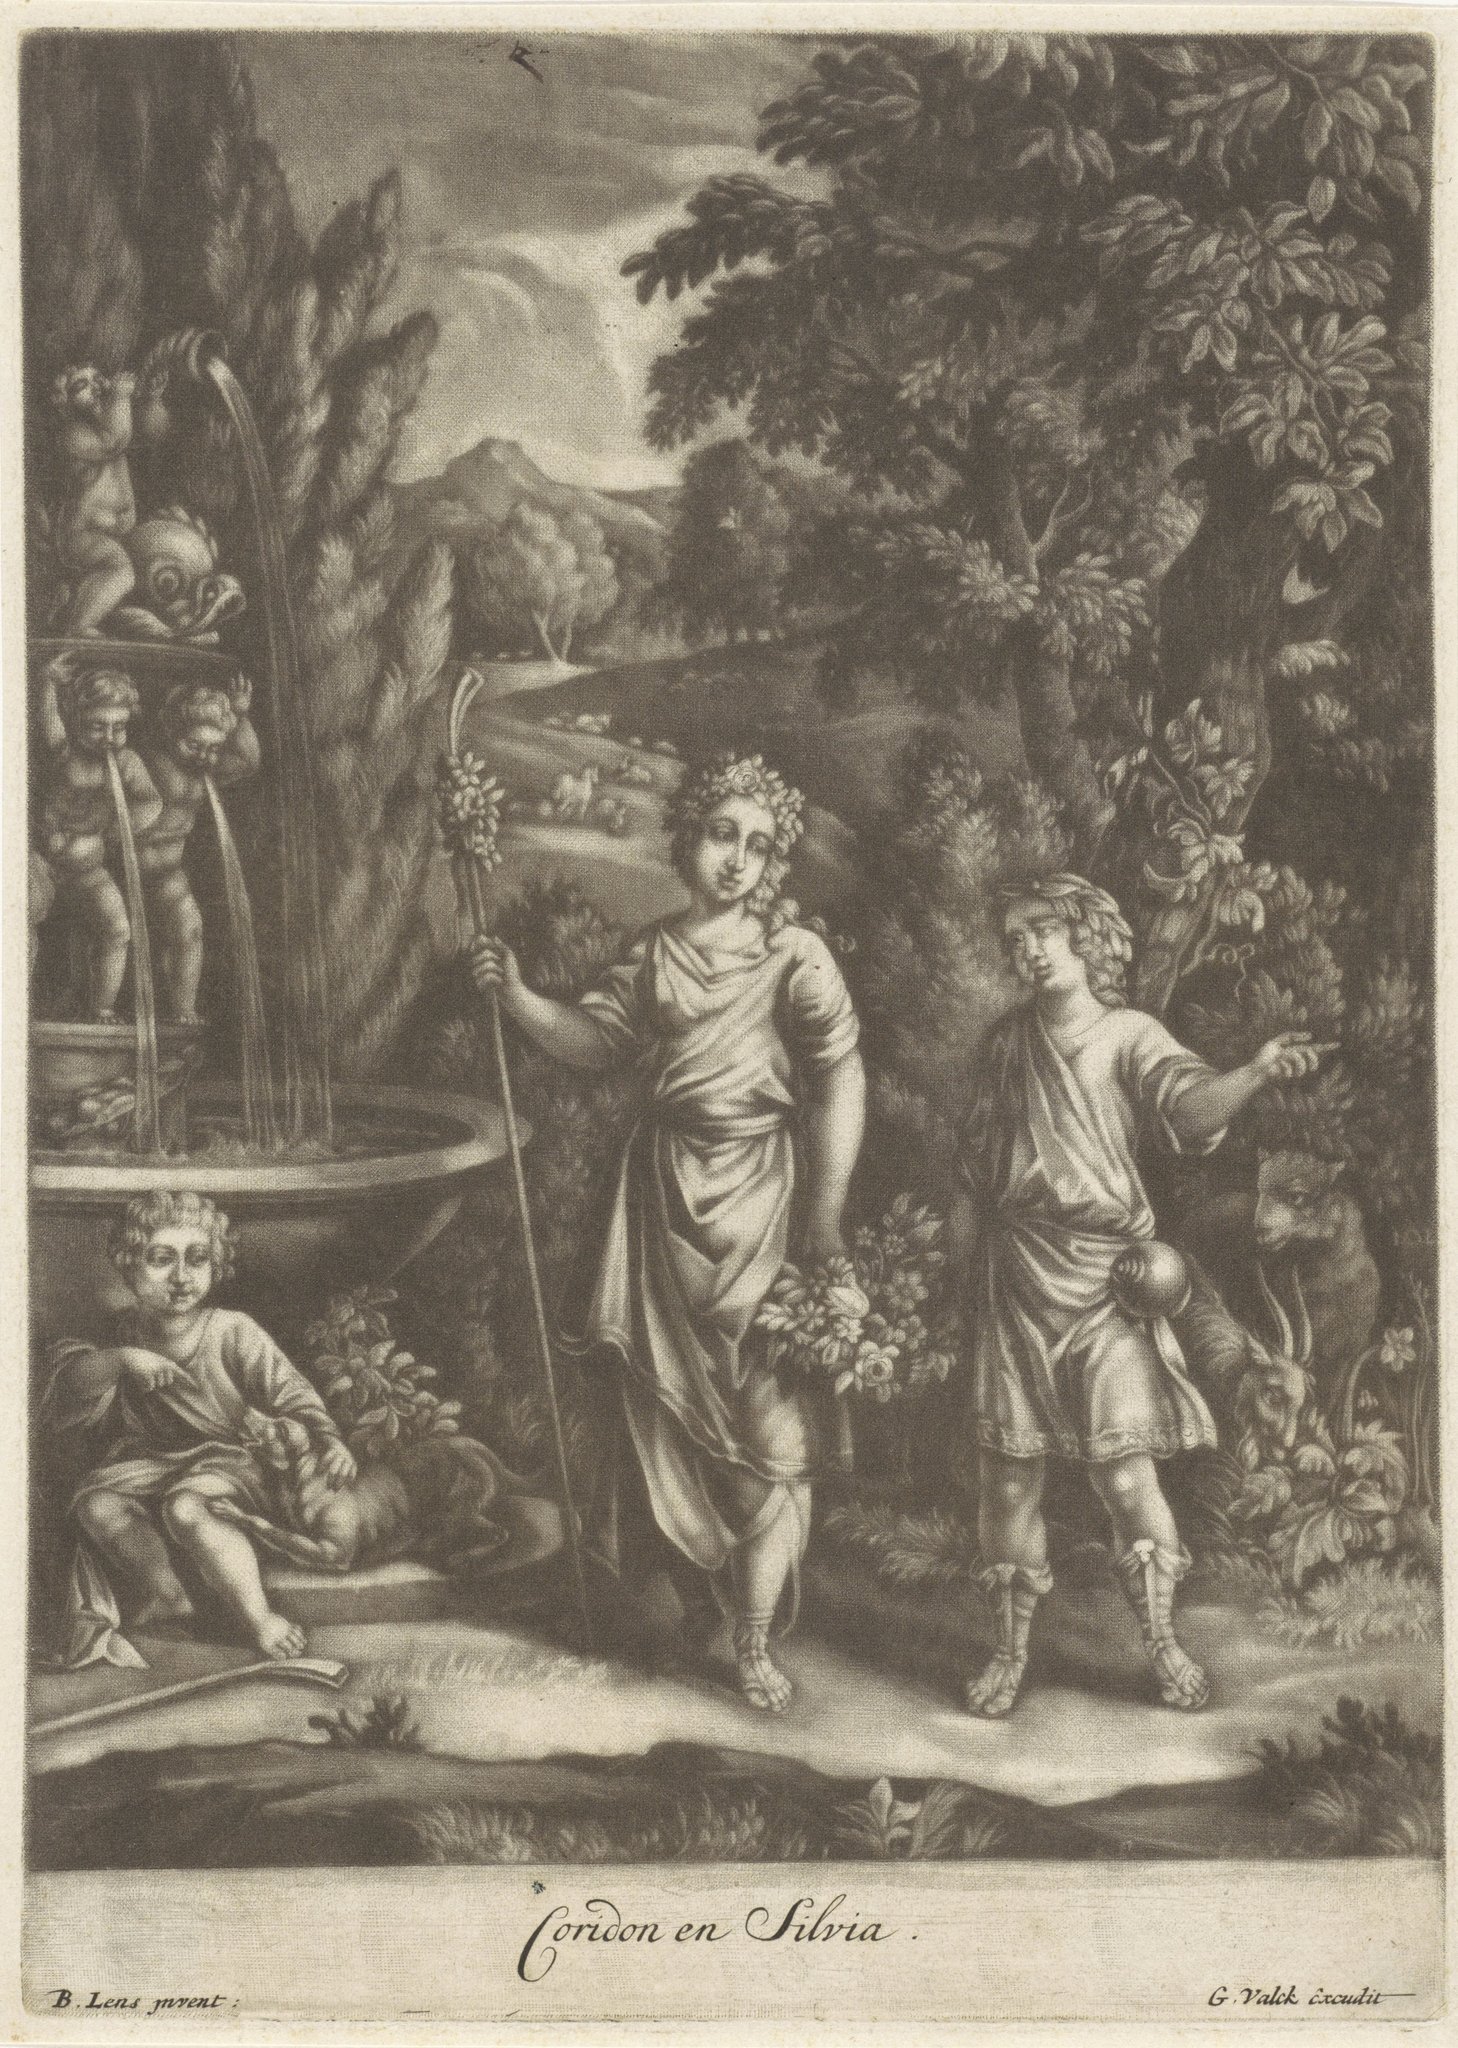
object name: print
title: Coridon en Silvia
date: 1662-1726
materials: paper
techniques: mezzotint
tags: herding, herdsman, herdswoman, shepherd, shepherdess, cowherd, etc., garden fountain, female literary characters (with name), male literary characters (with name), dog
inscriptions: collector's mark: Lugt 2228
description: In een heuvelachtig boslandschap lopen Coridon en Silvia als pastoraal liefdespaar naar een fontein. Silvia draagt een bloemenkrans in het haar en heeft een herdersstaf met bloemen in de hand. Samen dragen ze een korf met bloemen. Bij de fontein zit een jongen met een hond.